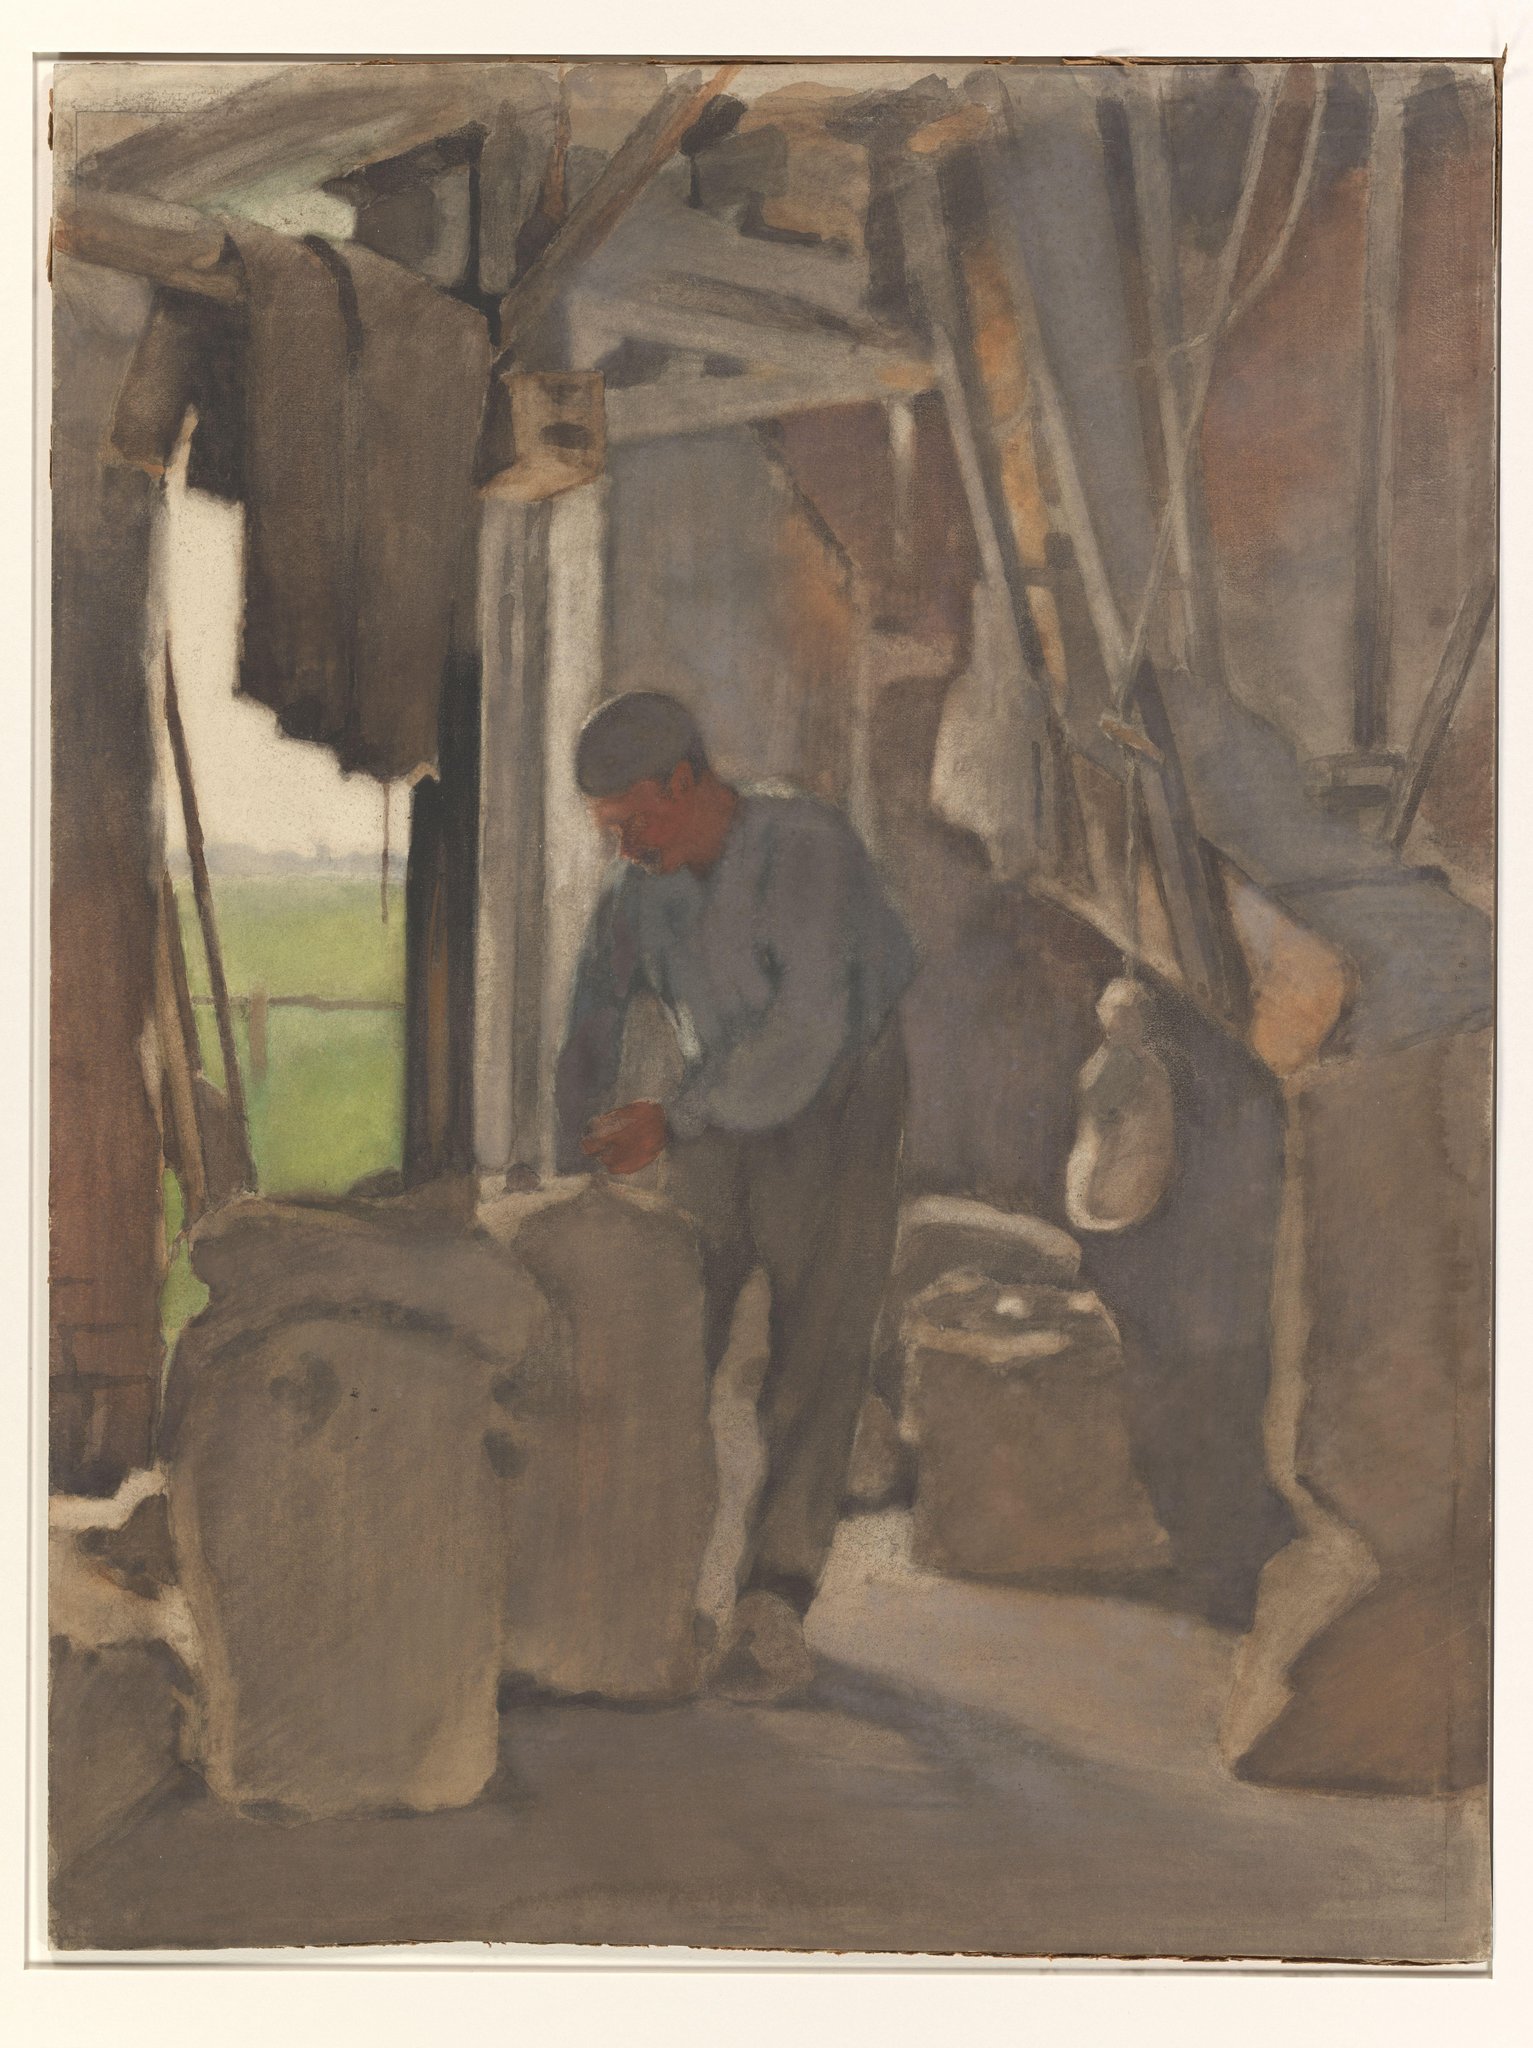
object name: drawing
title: De molenaar, zakken vullend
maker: willem witsen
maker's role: draughtsman, painter, print maker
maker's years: 1860-1923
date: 1870-1923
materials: cardboard, chalk, watercolor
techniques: brush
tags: miller